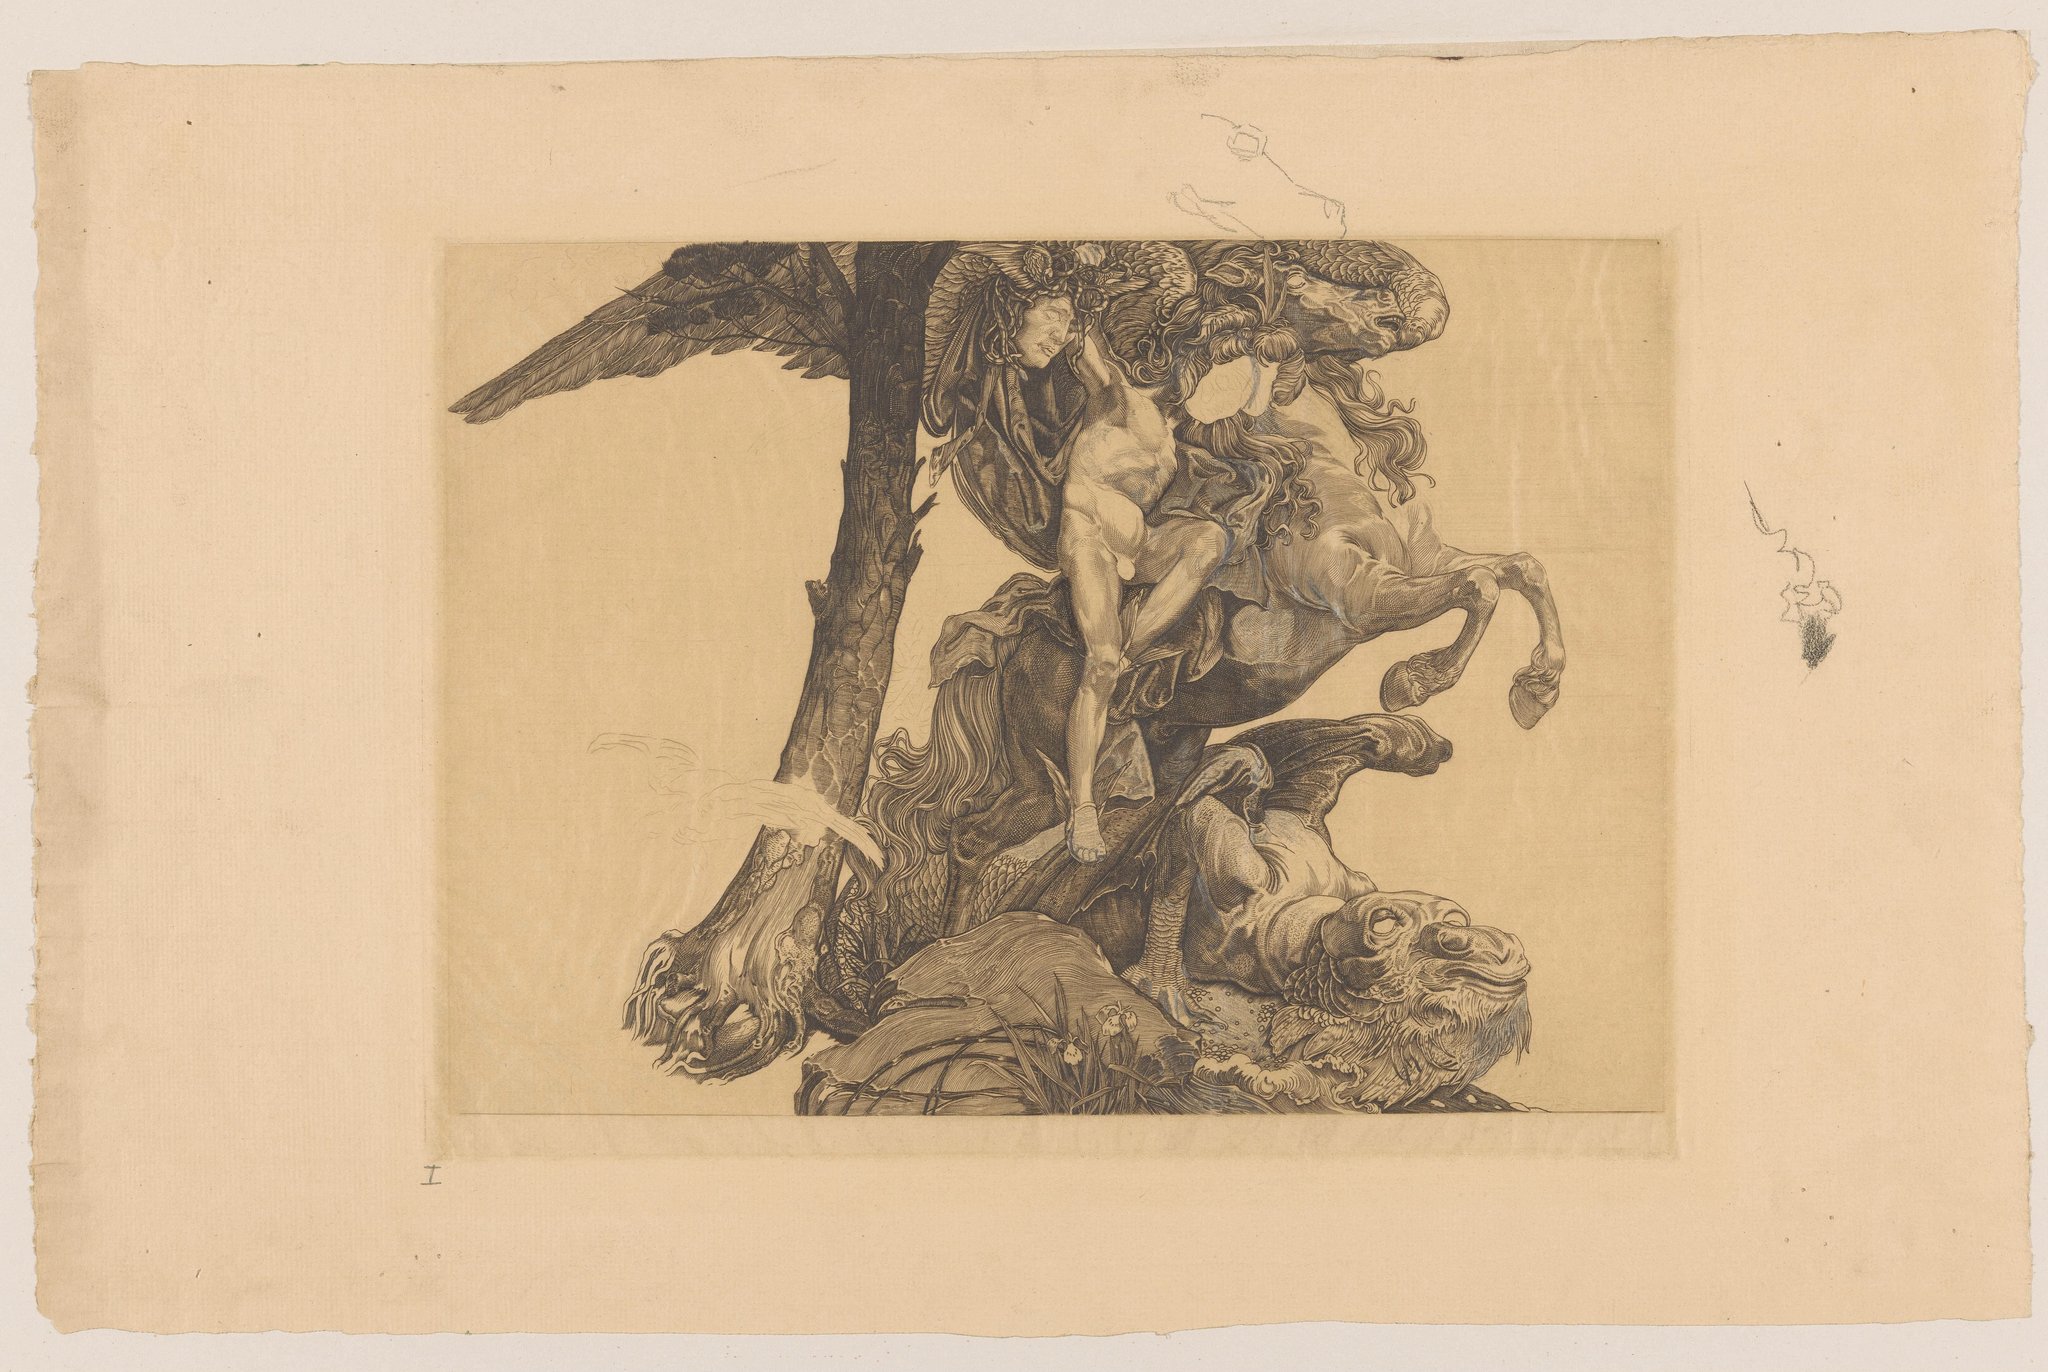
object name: print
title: Perseus en het zeemonster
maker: johannes josephus aarts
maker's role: draughtsman, print maker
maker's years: 1871-1934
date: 1907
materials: paper, pencil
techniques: engraving, intaglio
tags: pegasus, the winged horse, (story of) perseus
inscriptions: collector's mark: Lugt 2166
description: Perseus zweeft hangend aan het gevleugelde paard Pegasus door de lucht. Hij houdt het afgehakte hoofd van Medusa boven het zeemonster waaraan Andromeda is geofferd. Links op de voorgrond een vliegende meeuw.